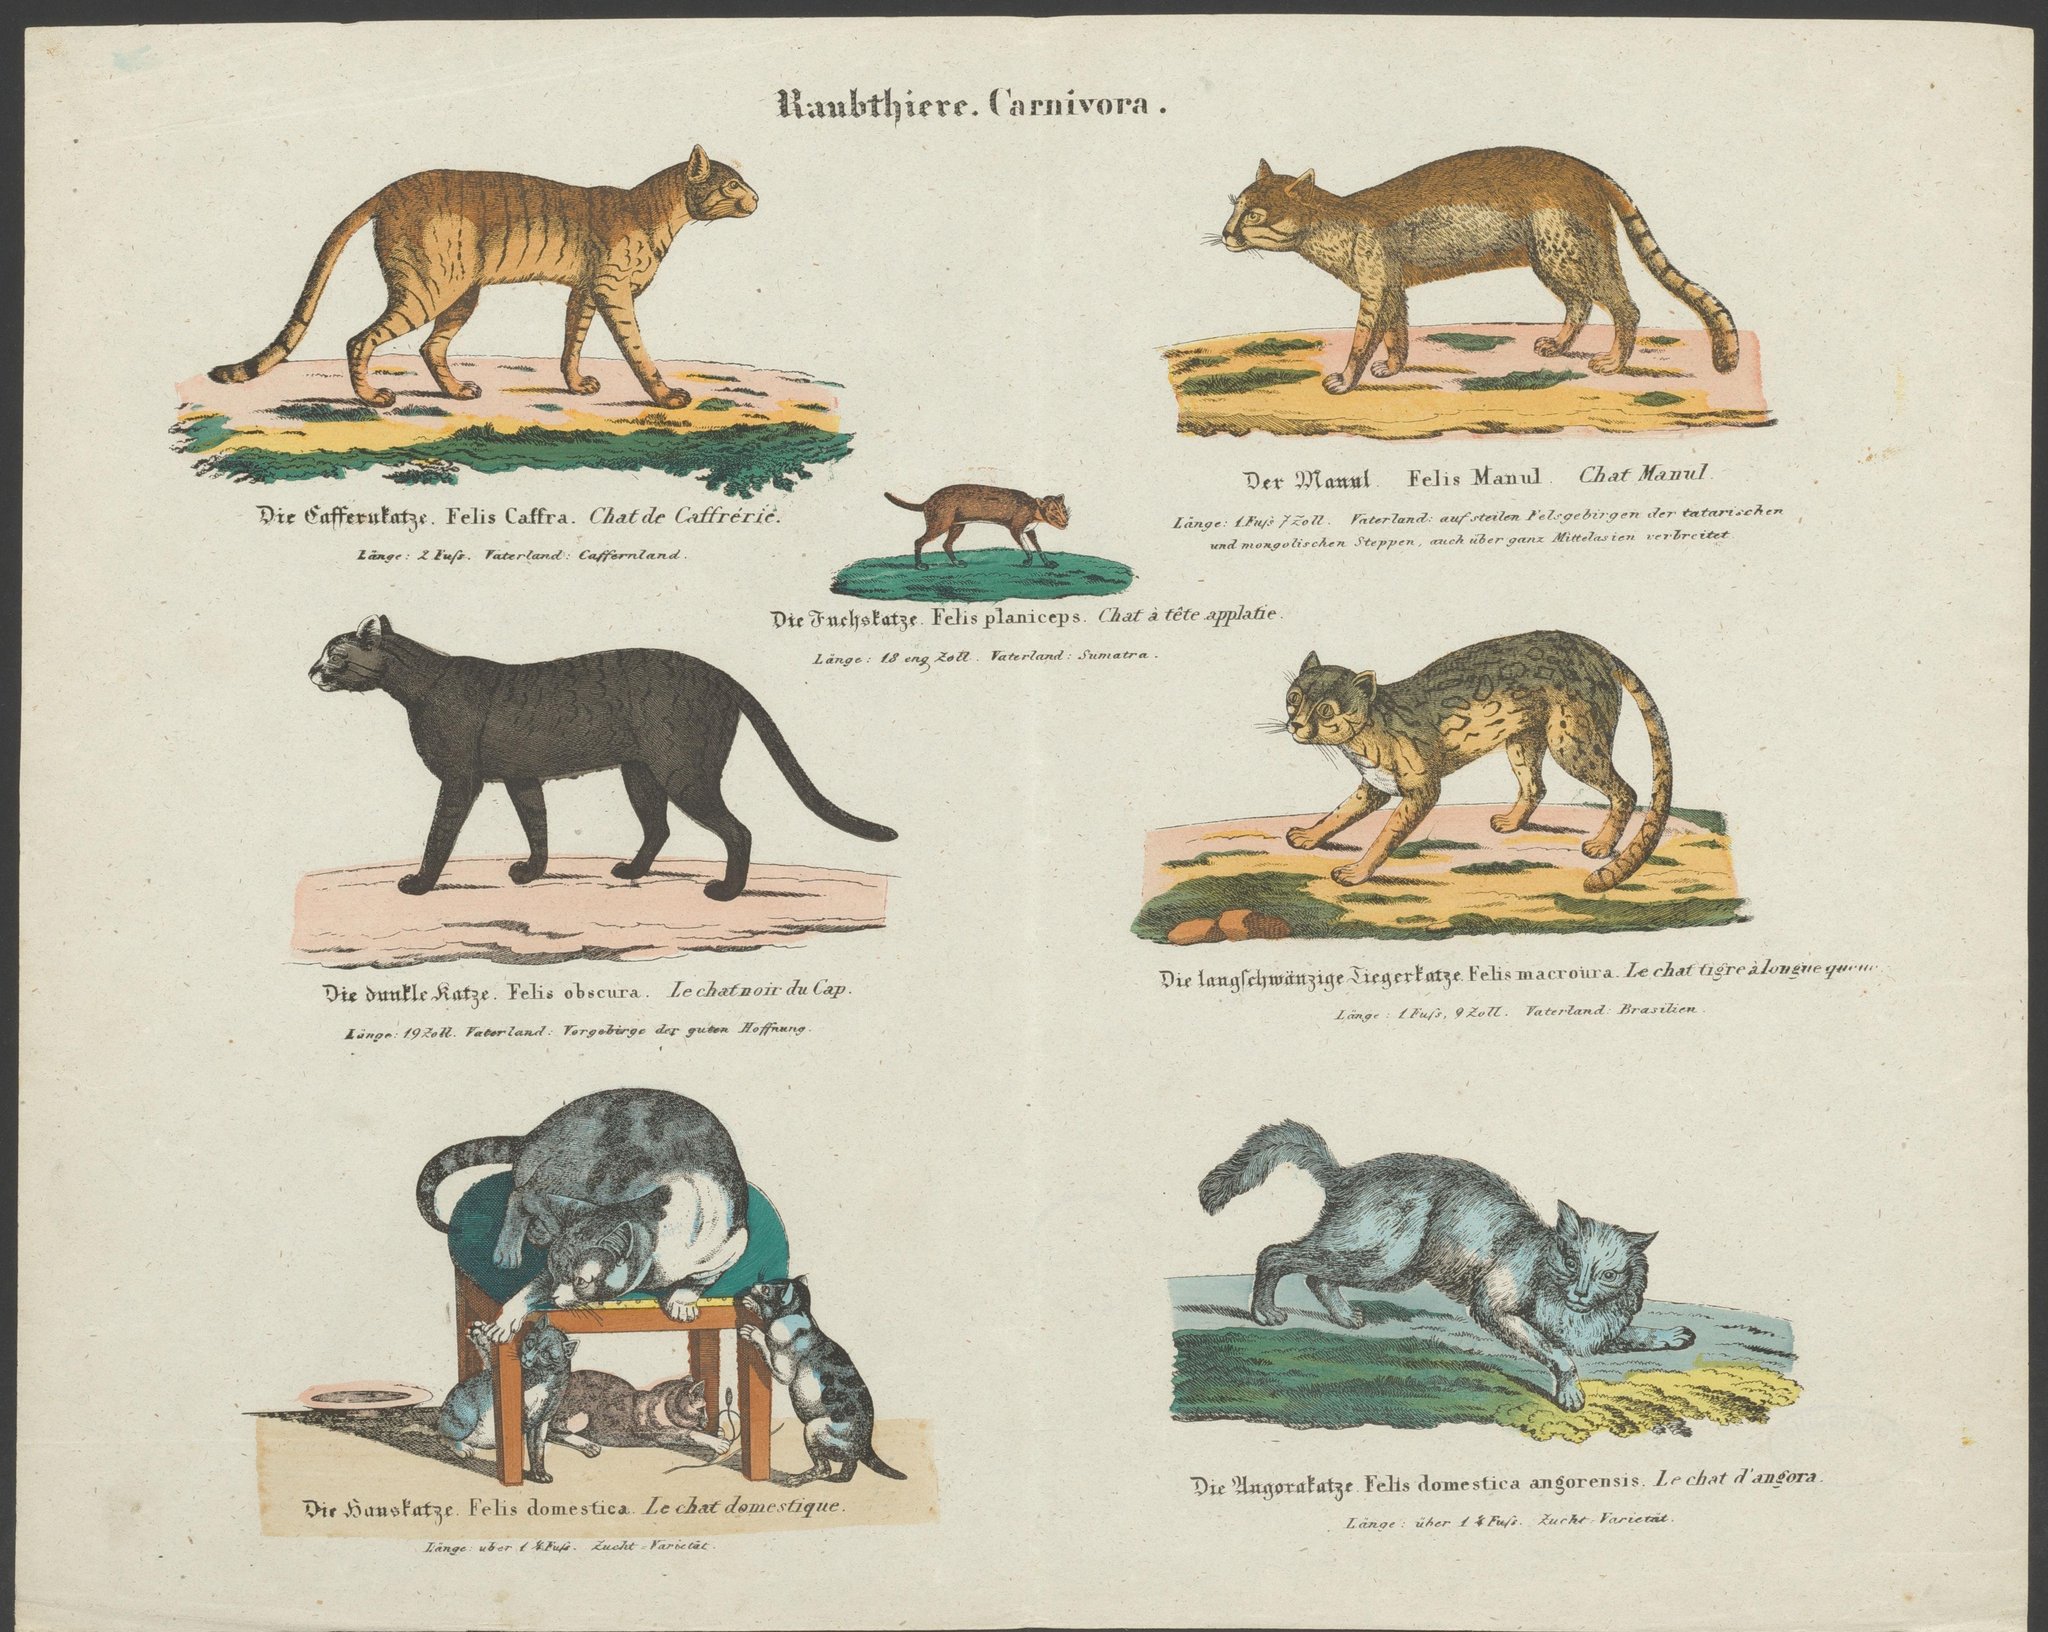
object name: print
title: Raubthiere.Carnivora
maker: Anonymous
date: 1837-1868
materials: paper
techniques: hand coloring, lithograph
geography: nuremberg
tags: cat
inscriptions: collector's mark: Lugt 1641, stamp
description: Zeven voorstellingen van diverse soorten katachtige. Onder iedere voorstelling de naam van het soort in het Duits, Latijn en Frans. Daaronder de afmeting en land van herkomst van het dier. Onderwerpsrubrieken binnen de Atlas Zeden en Gewoonten: Zeden en Gewoonten in Engeren Zin, Des menschen beging, midden en einde, Kinderleven – Kinderspel en Kinderprenten.